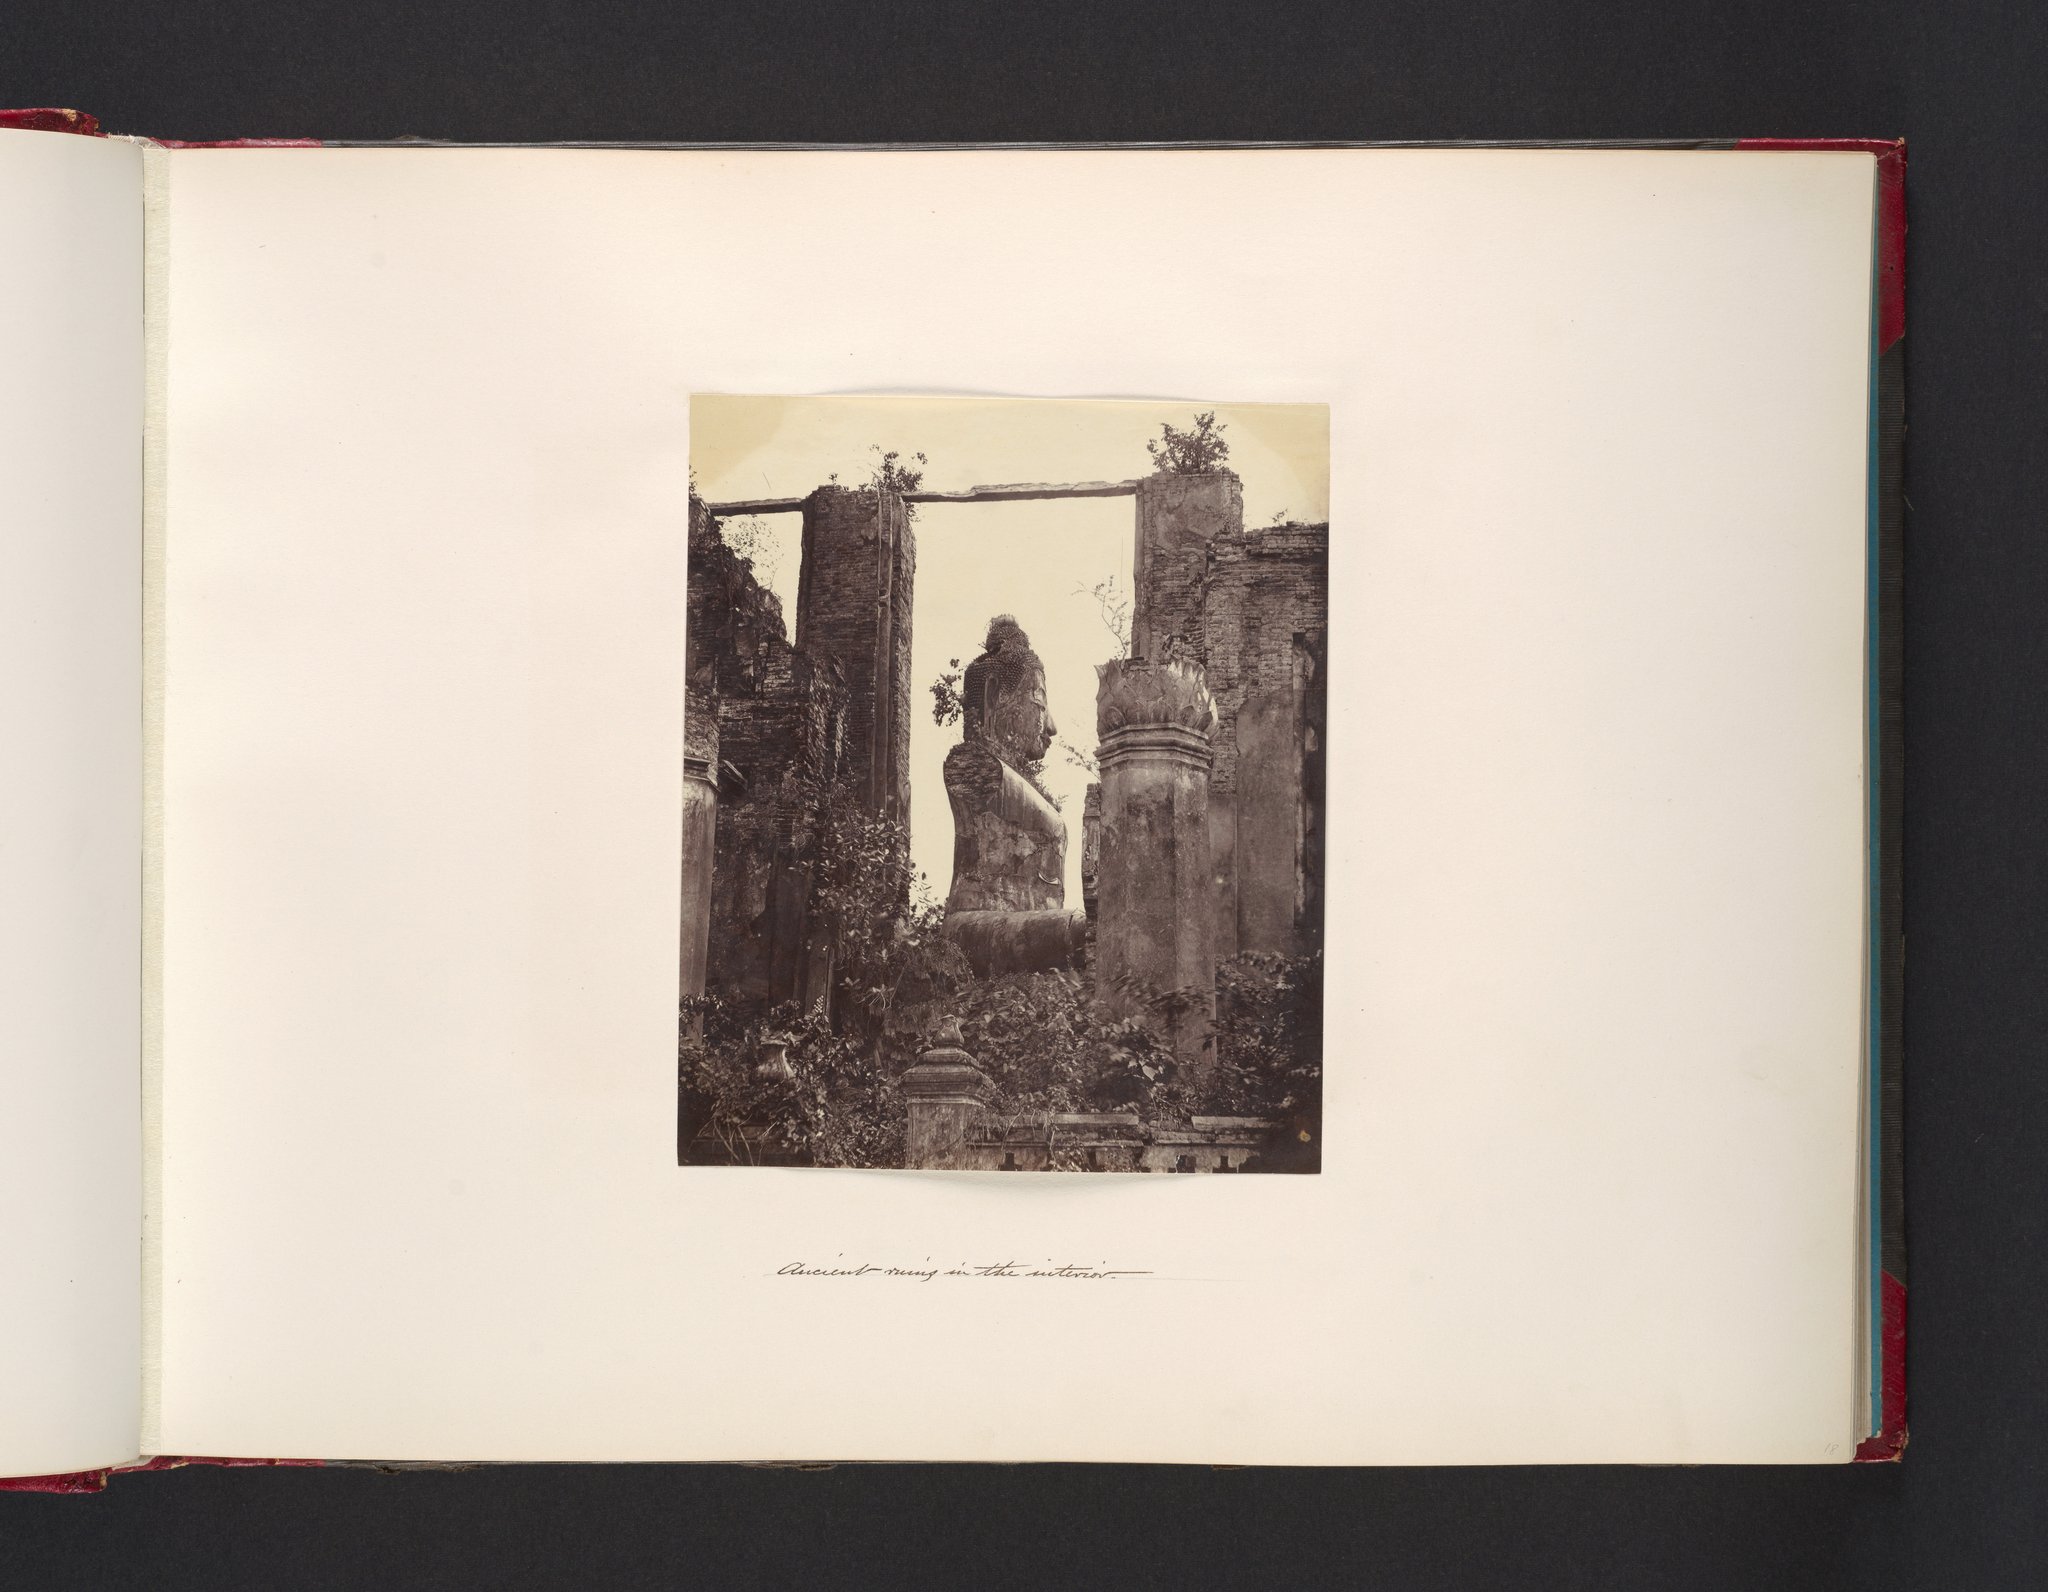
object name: photograph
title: Ancient Ruins in the Interior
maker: john thomson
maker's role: artist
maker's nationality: british, scottish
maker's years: 1837-1921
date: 1865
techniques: albumen silver print, glass negative